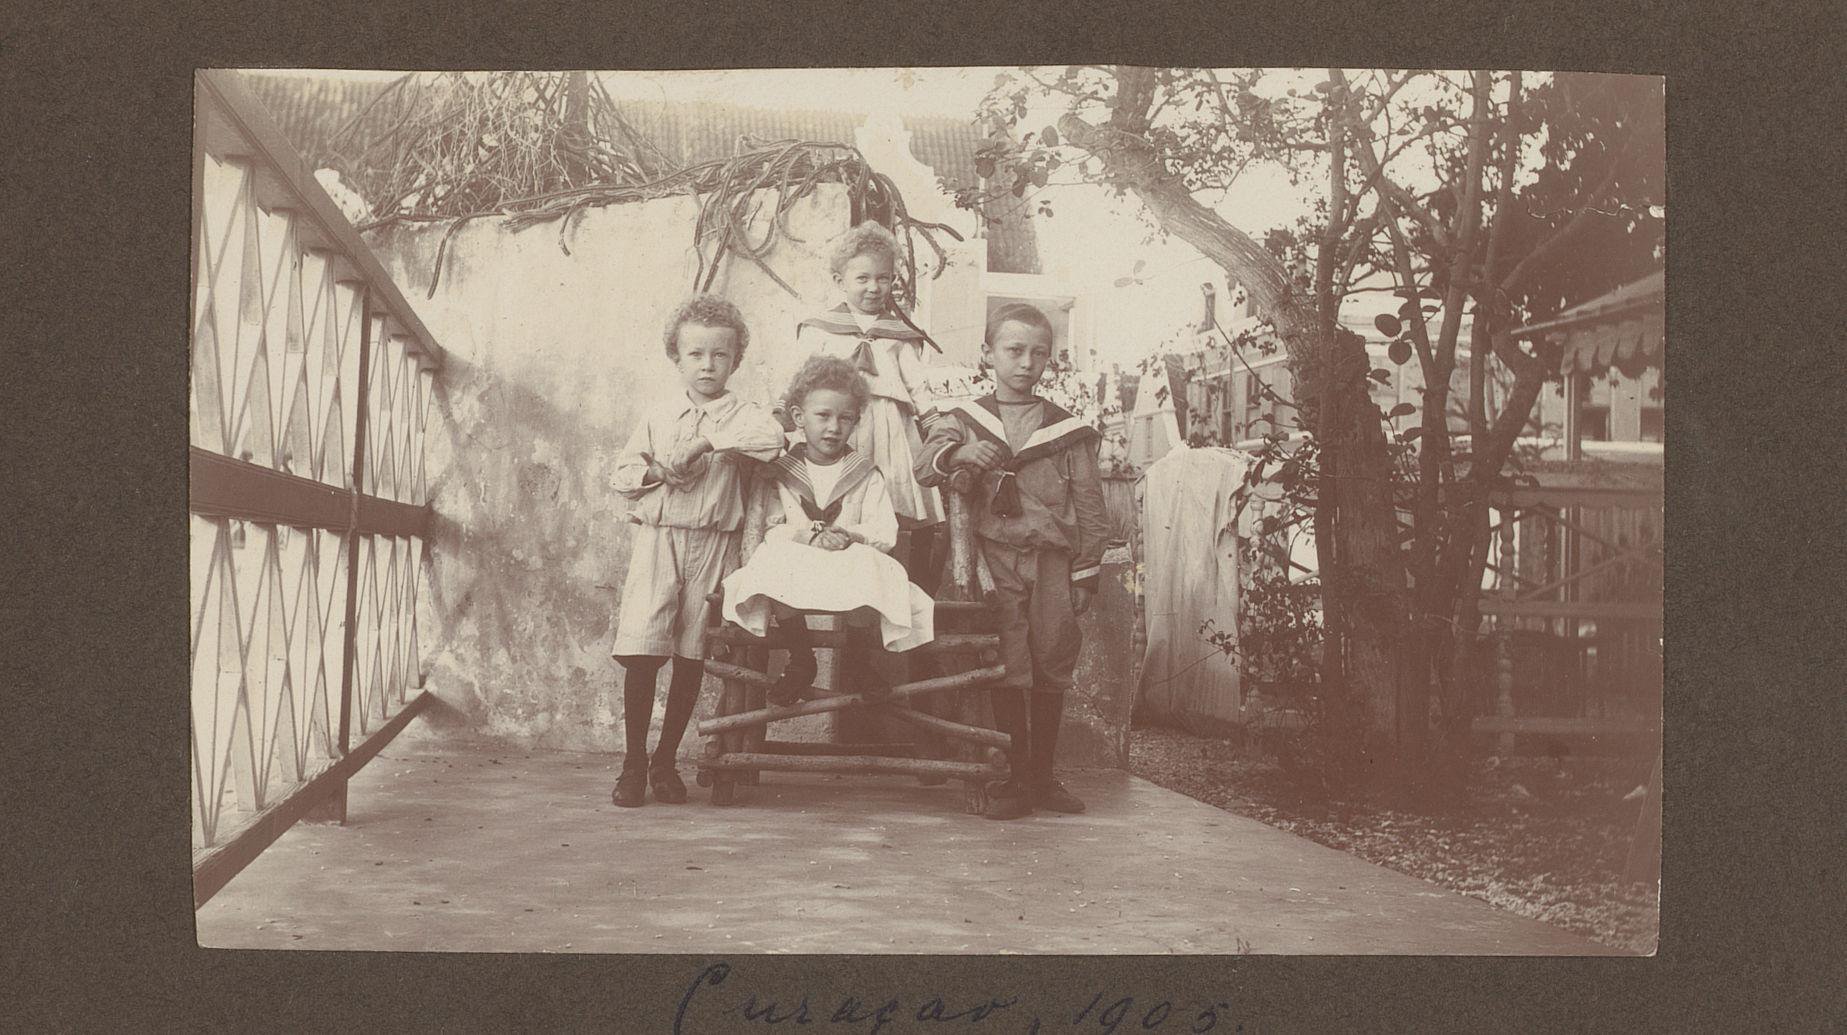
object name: photograph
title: Portret van vier kinderen buiten op een houten bank in Curaçao, vermoedelijk de kinderen van Jan Olphert de Jong van Beek en Donk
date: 1905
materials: paper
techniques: collodion silver print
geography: curacao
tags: boy (child between toddler and youth), anonymous historical persons portrayed in a group, in a group-portrait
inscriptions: address and date: ‘Curacao, 1905.’